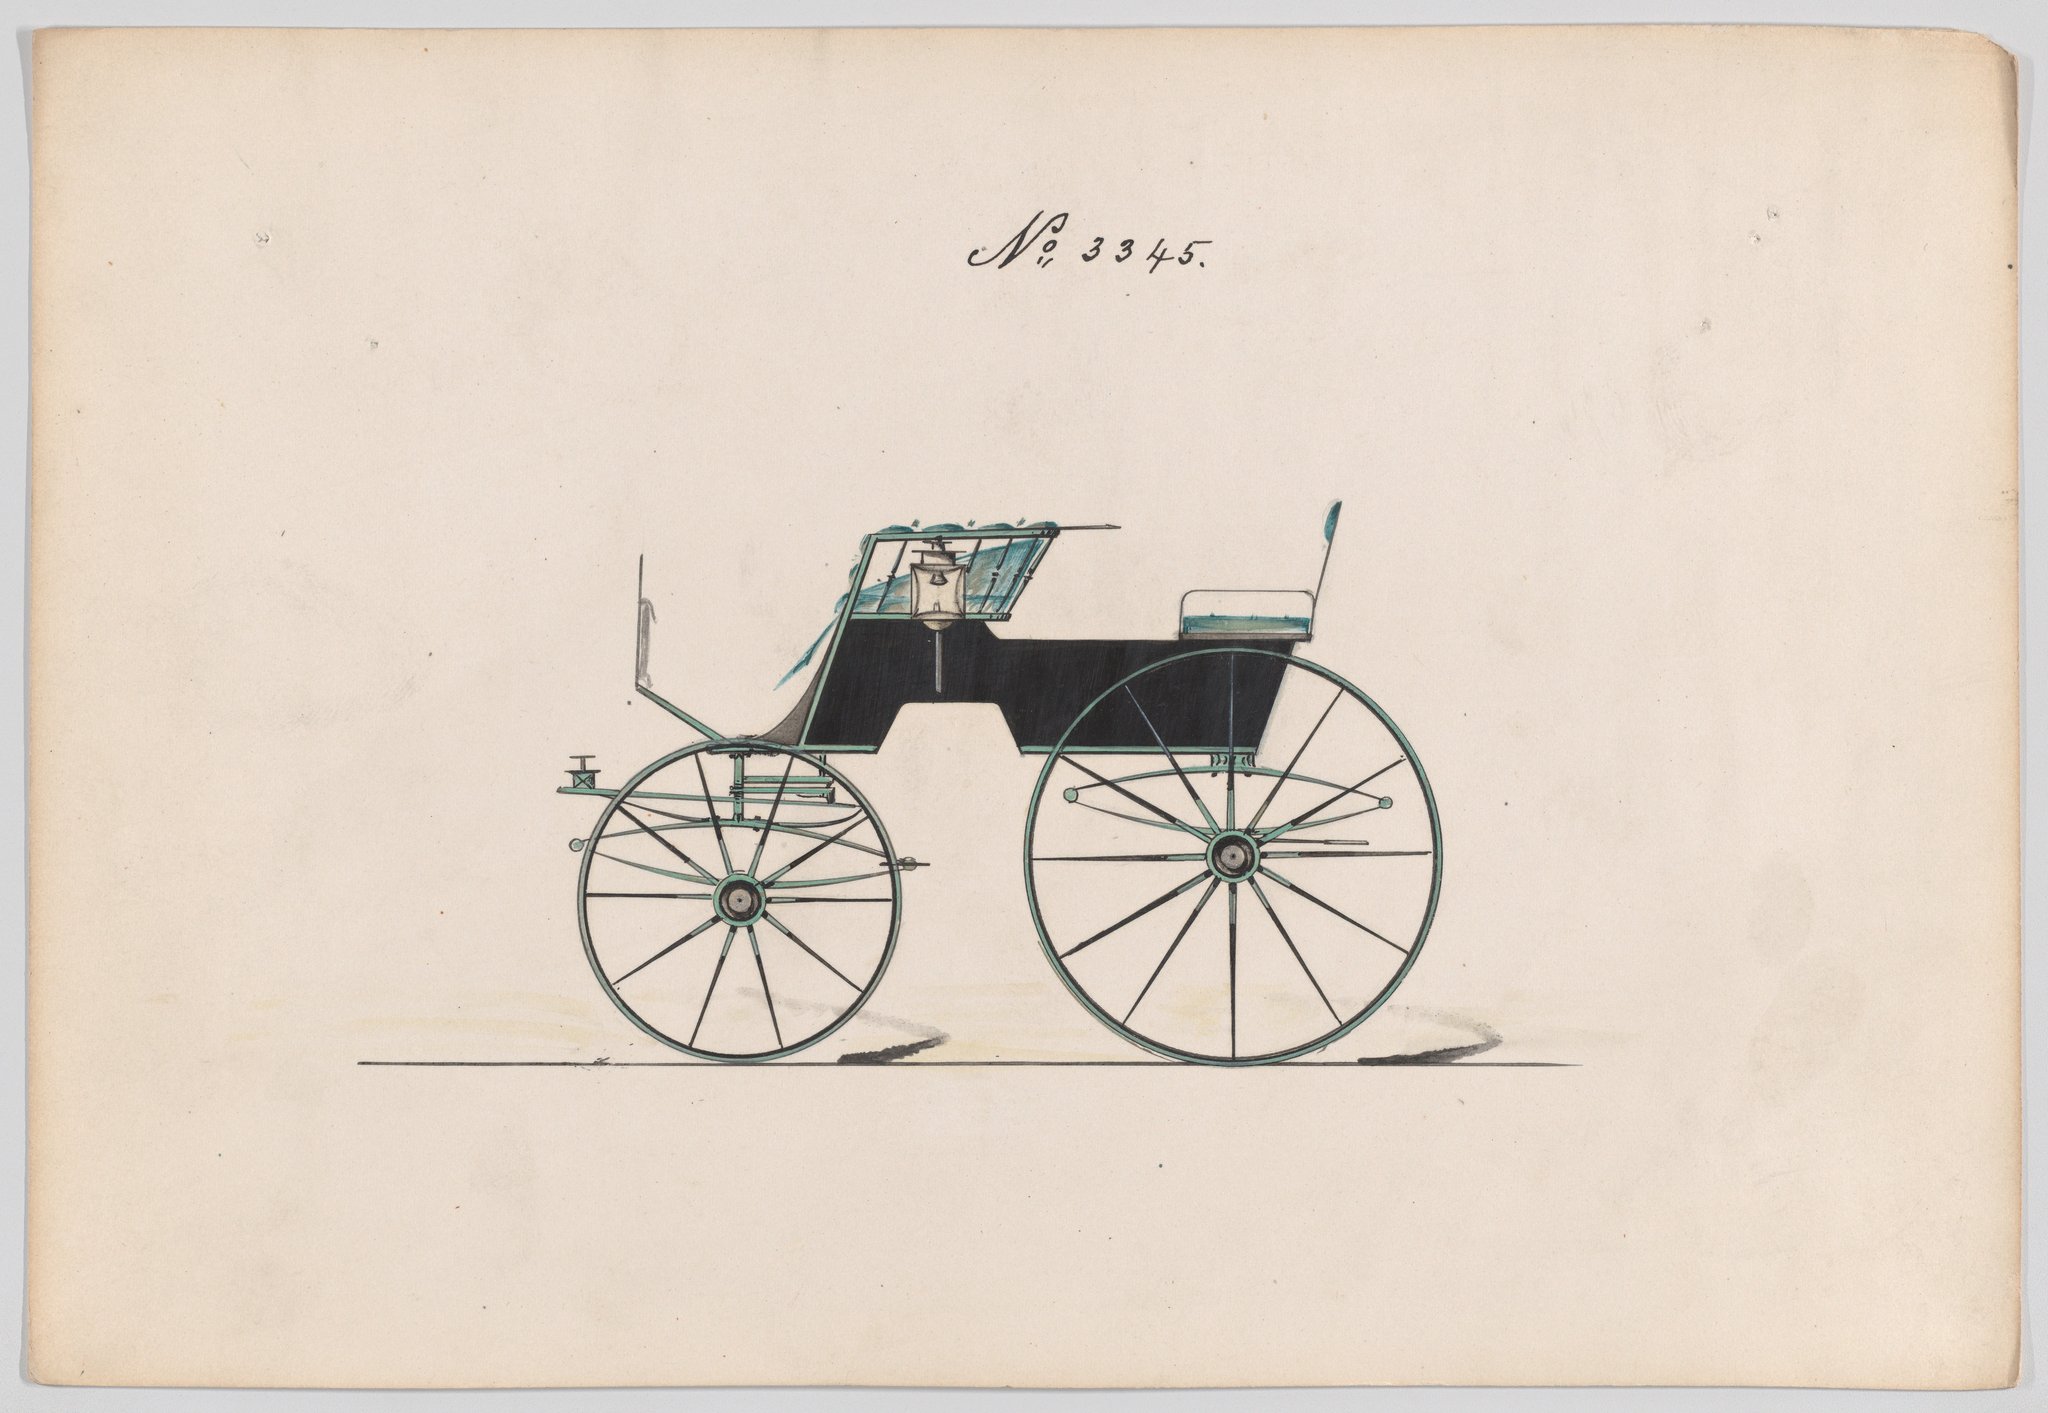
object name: drawing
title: Design for T-Cart, no. 3345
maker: brewster & co.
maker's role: manufacturer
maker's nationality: american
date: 1877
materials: gouache, gum arabic, ink, watercolor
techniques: pen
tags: carriages